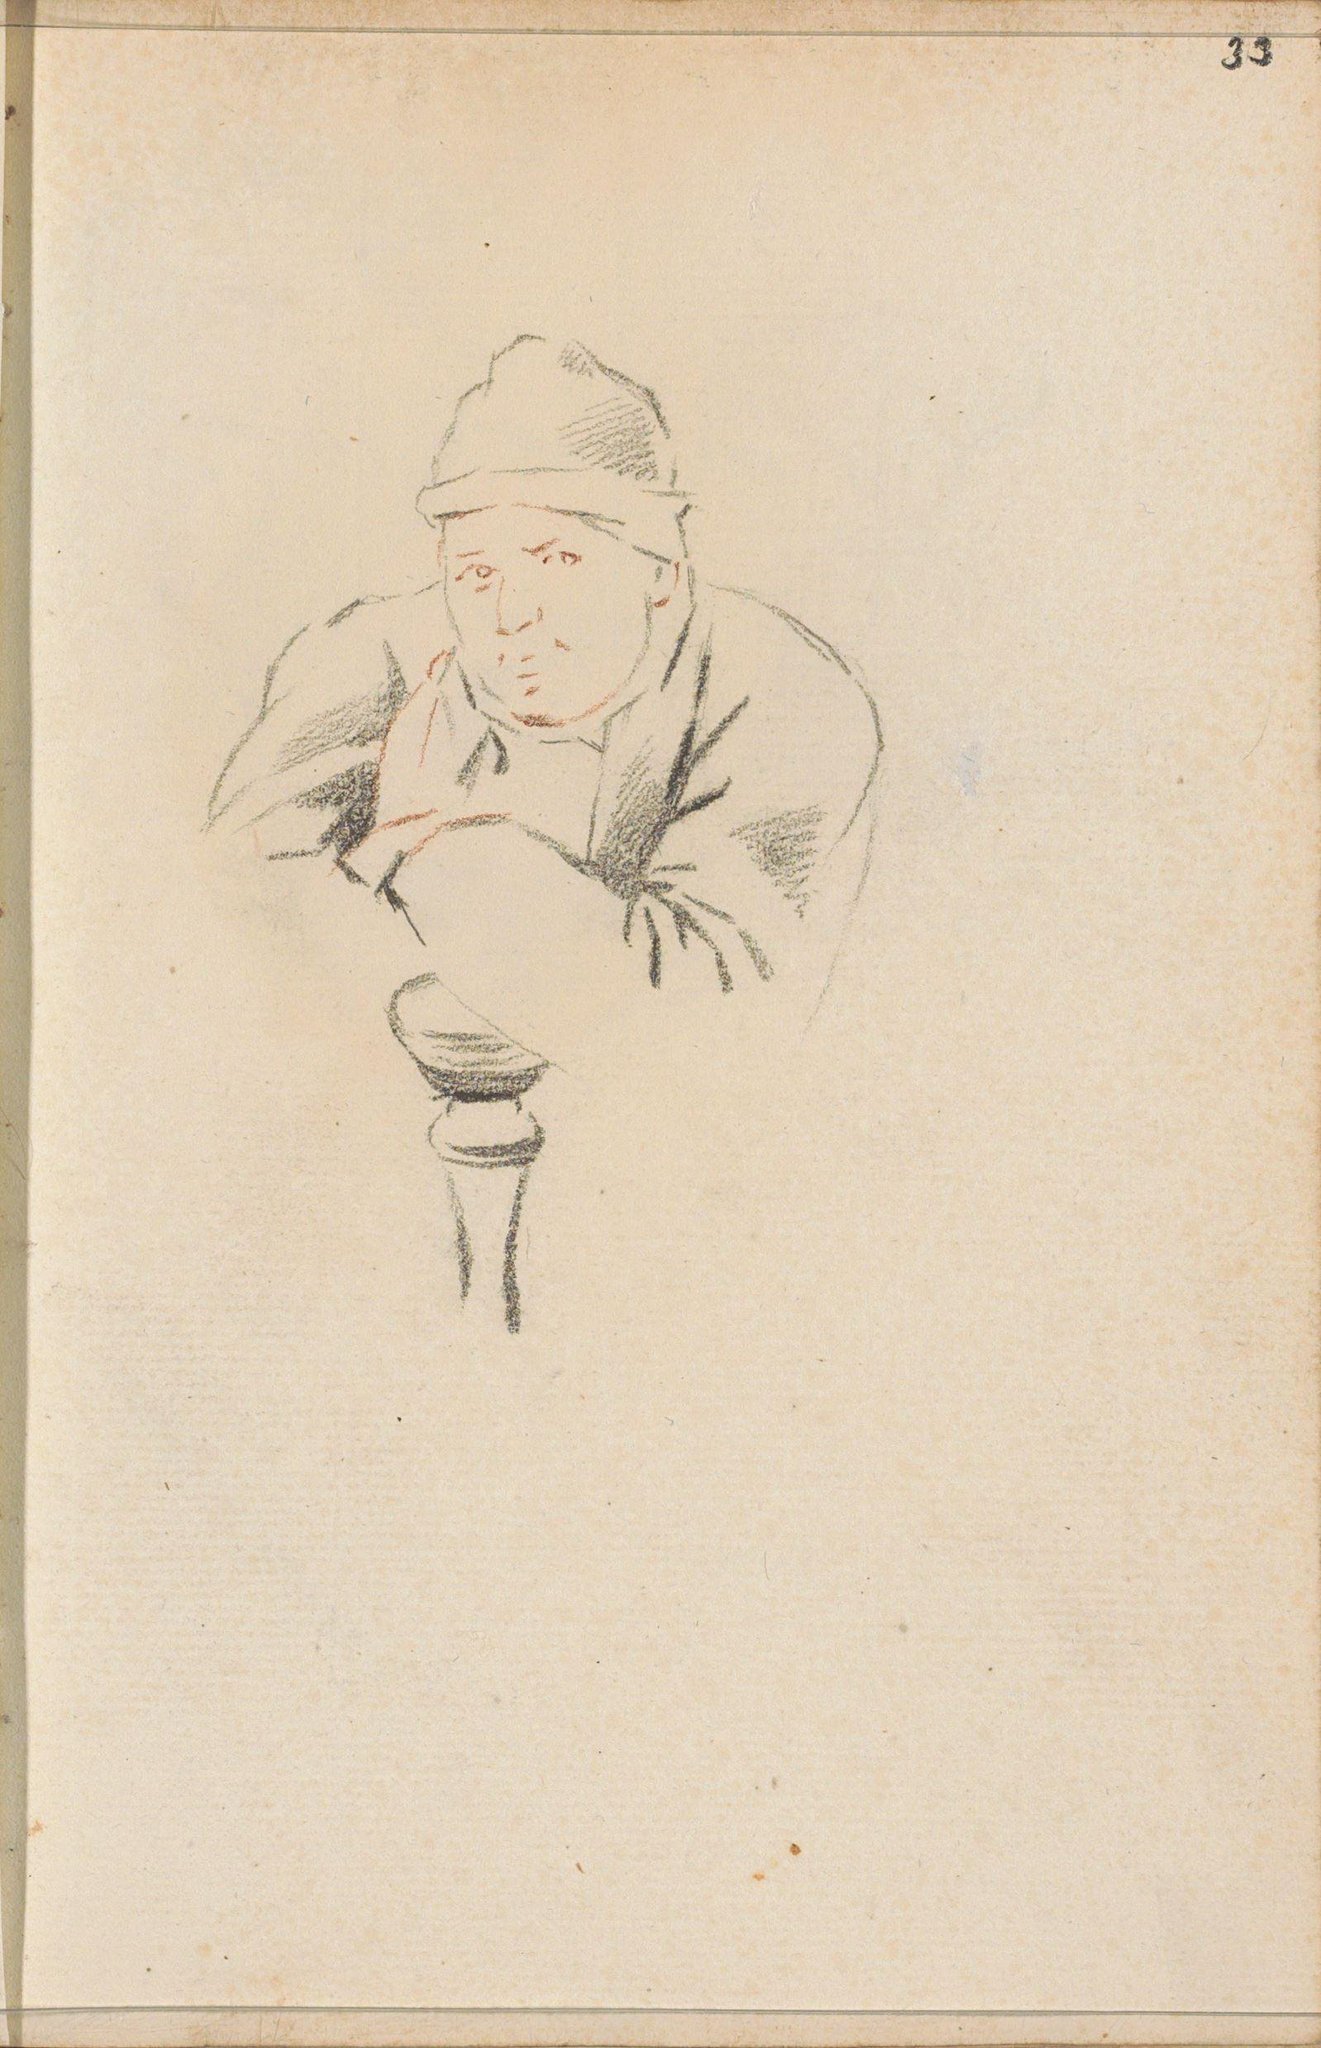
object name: sketchbook leaf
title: Man steunend op een pilaar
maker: jacob perkois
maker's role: draughtsman, print maker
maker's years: 1756-1804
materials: chalk, paper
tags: leaning figure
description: Bladzijde 33 uit een schetsboek met 78 bladzijden.